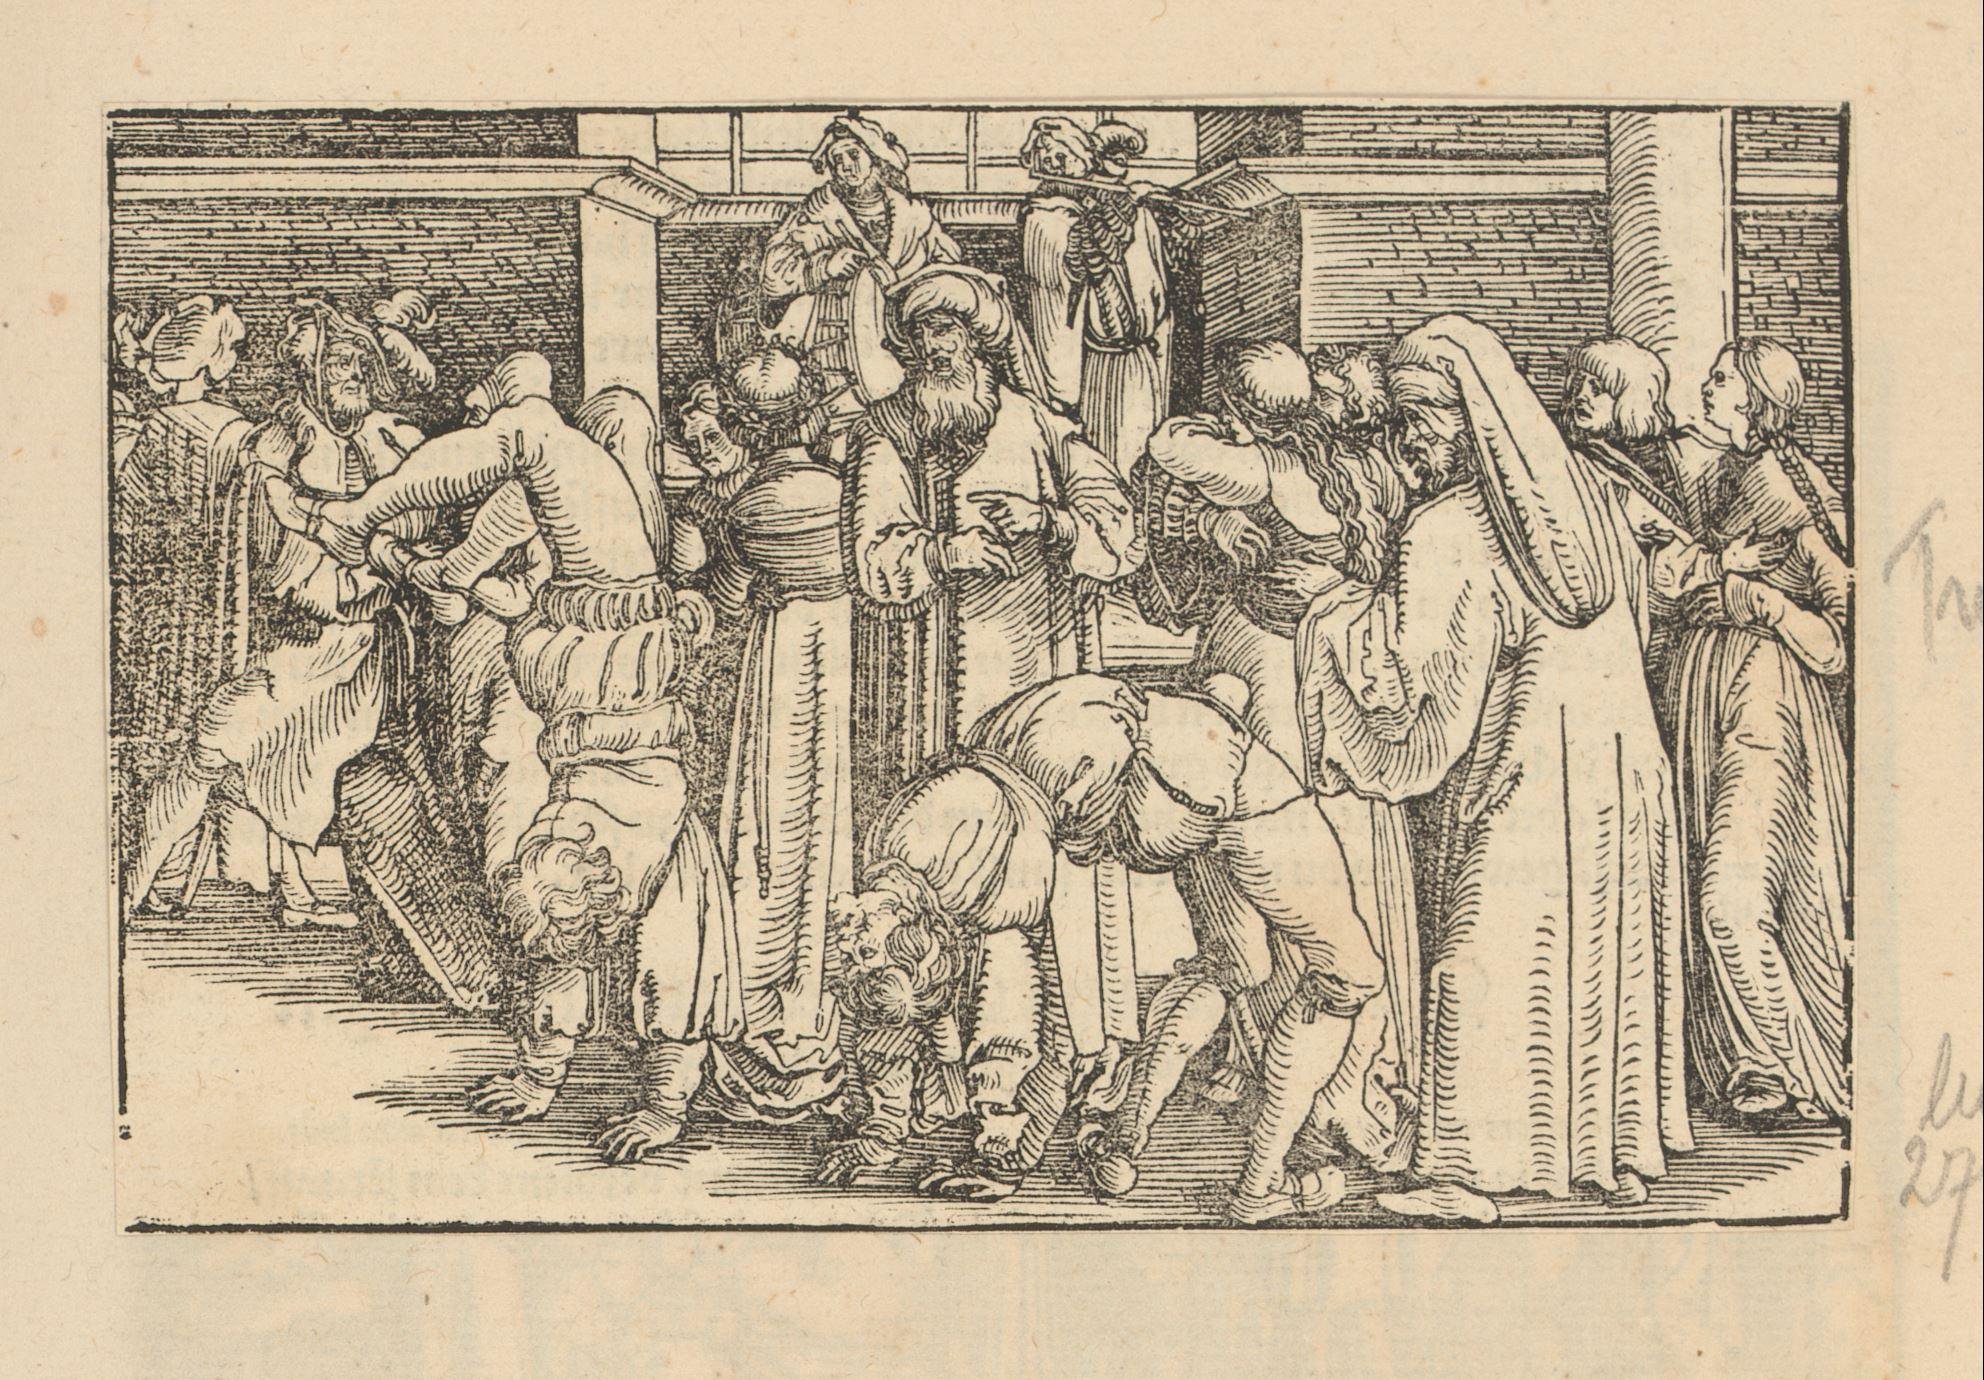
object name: print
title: Twee oude mannen keuren een optreden van acrobaten af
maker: Anonymous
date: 1514-1532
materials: paper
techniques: letterpress printing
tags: disapprobation, disapproval, rebuking, acrobat ~ circus (+ the public ~ festive activities)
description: Deze prent is gebruikt in: Petrarca, Francesco. Von der Artzney bayder Glück, des guten und widerwertigen: unnd weß sich ain yeder inn Gelück und Unglück halten sol (...). Augsburg: Heinrich Steiner, 1532. Deze uitgave is ook bekend onder de titel 'Trostspiegel in Glück und Unglück'.